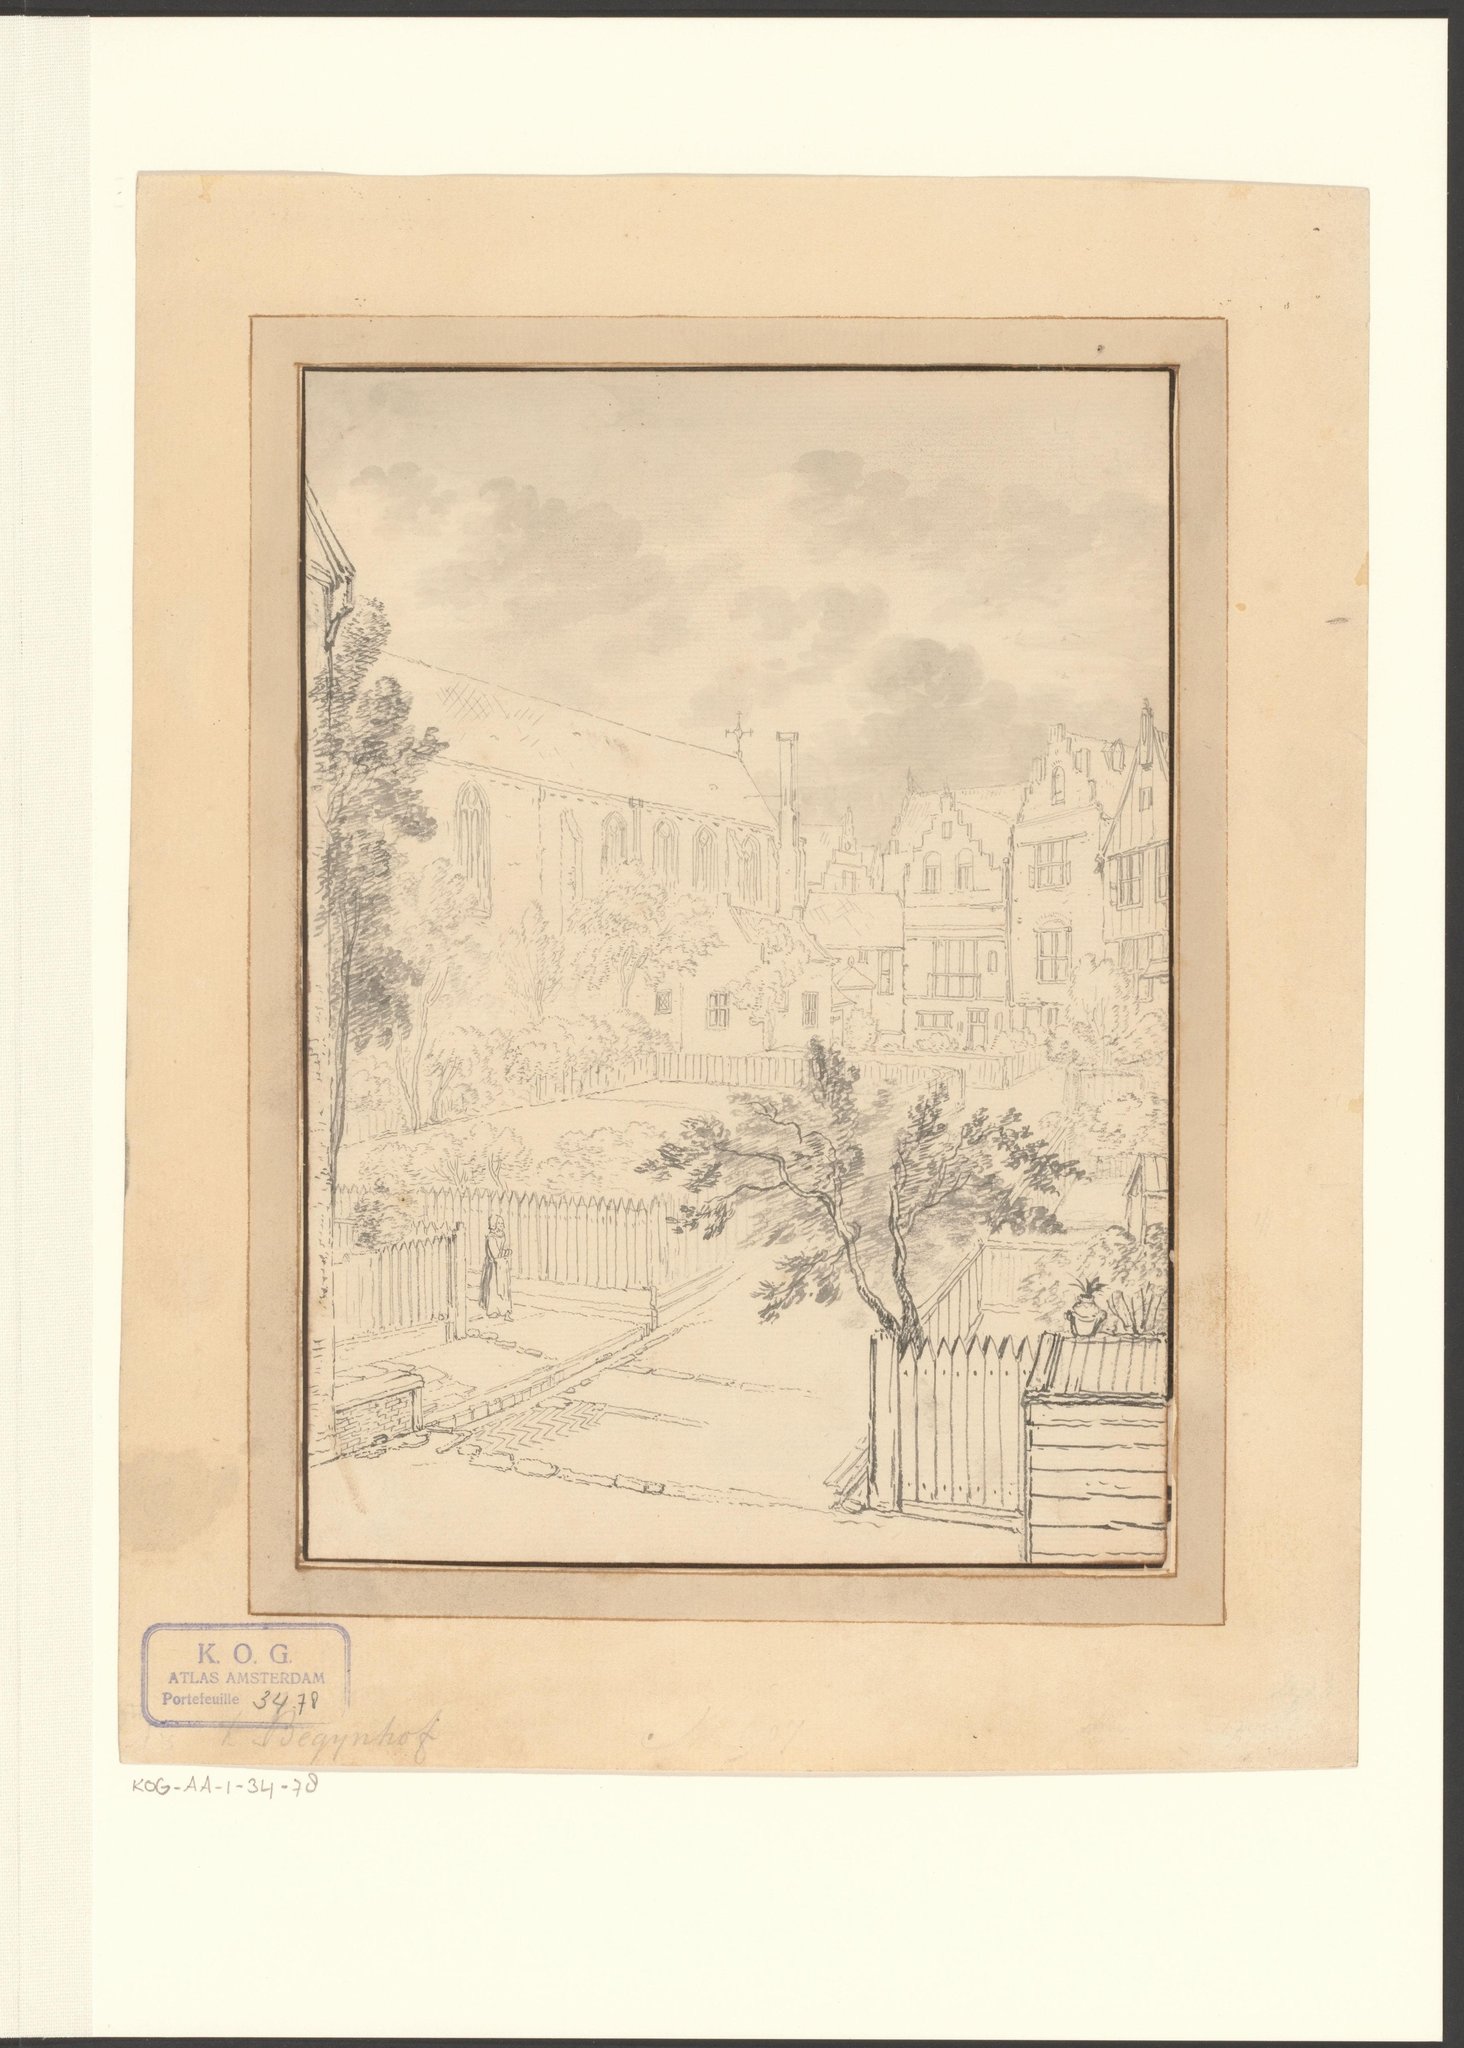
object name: drawing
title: Gezicht op het Begijnhof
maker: Anonymous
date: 1700-1799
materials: ink, paper, pencil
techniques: brush, pen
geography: amsterdam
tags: alms-house (dutch: 'hofje'), city-view in general; 'veduta'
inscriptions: inscription: ‘gesigt van 't bagijn hof tot Amsterdam / van binne, nevens de Engelse kerk te zien.’, collector's mark: ‘34.78’ Lugt 1641b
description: Onderwerpsrubriek binnen de Atlas Amsterdam: Begijnhof, t/m Petrus en Paulus.